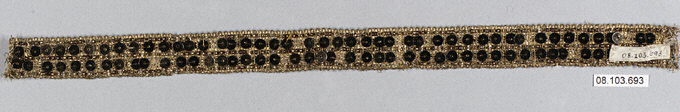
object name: passementerie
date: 1801-1833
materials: metal